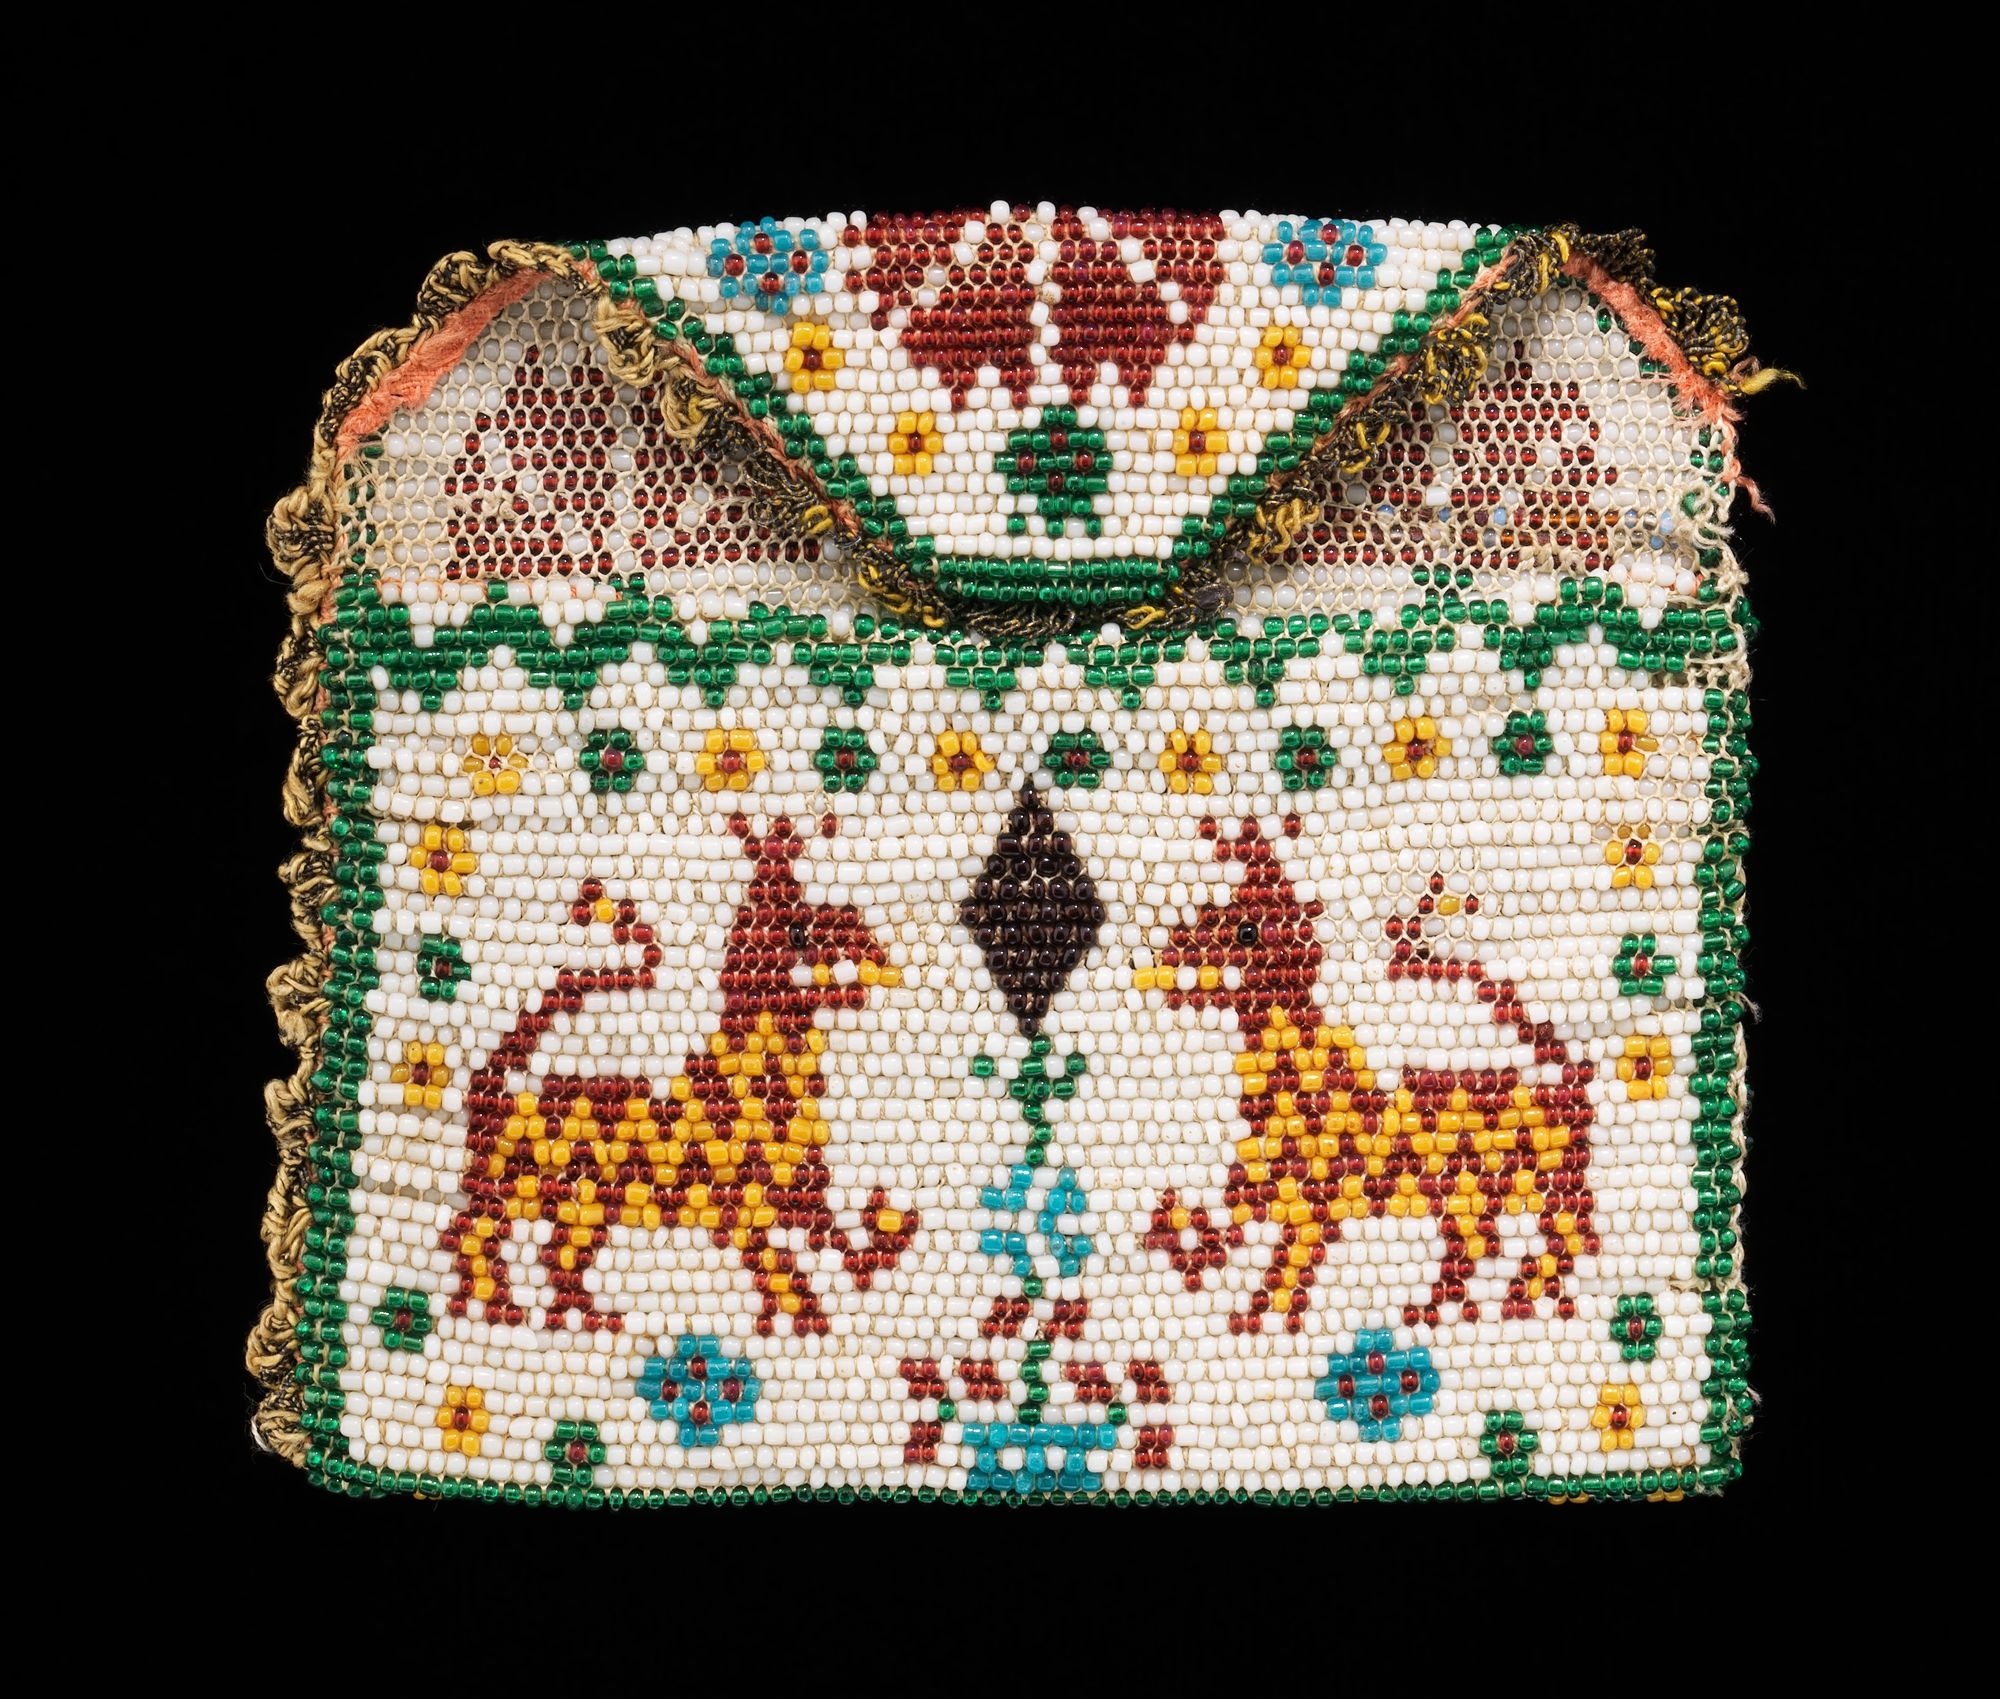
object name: coin purse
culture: mexican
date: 1790-1810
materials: glass, metal, silk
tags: lions